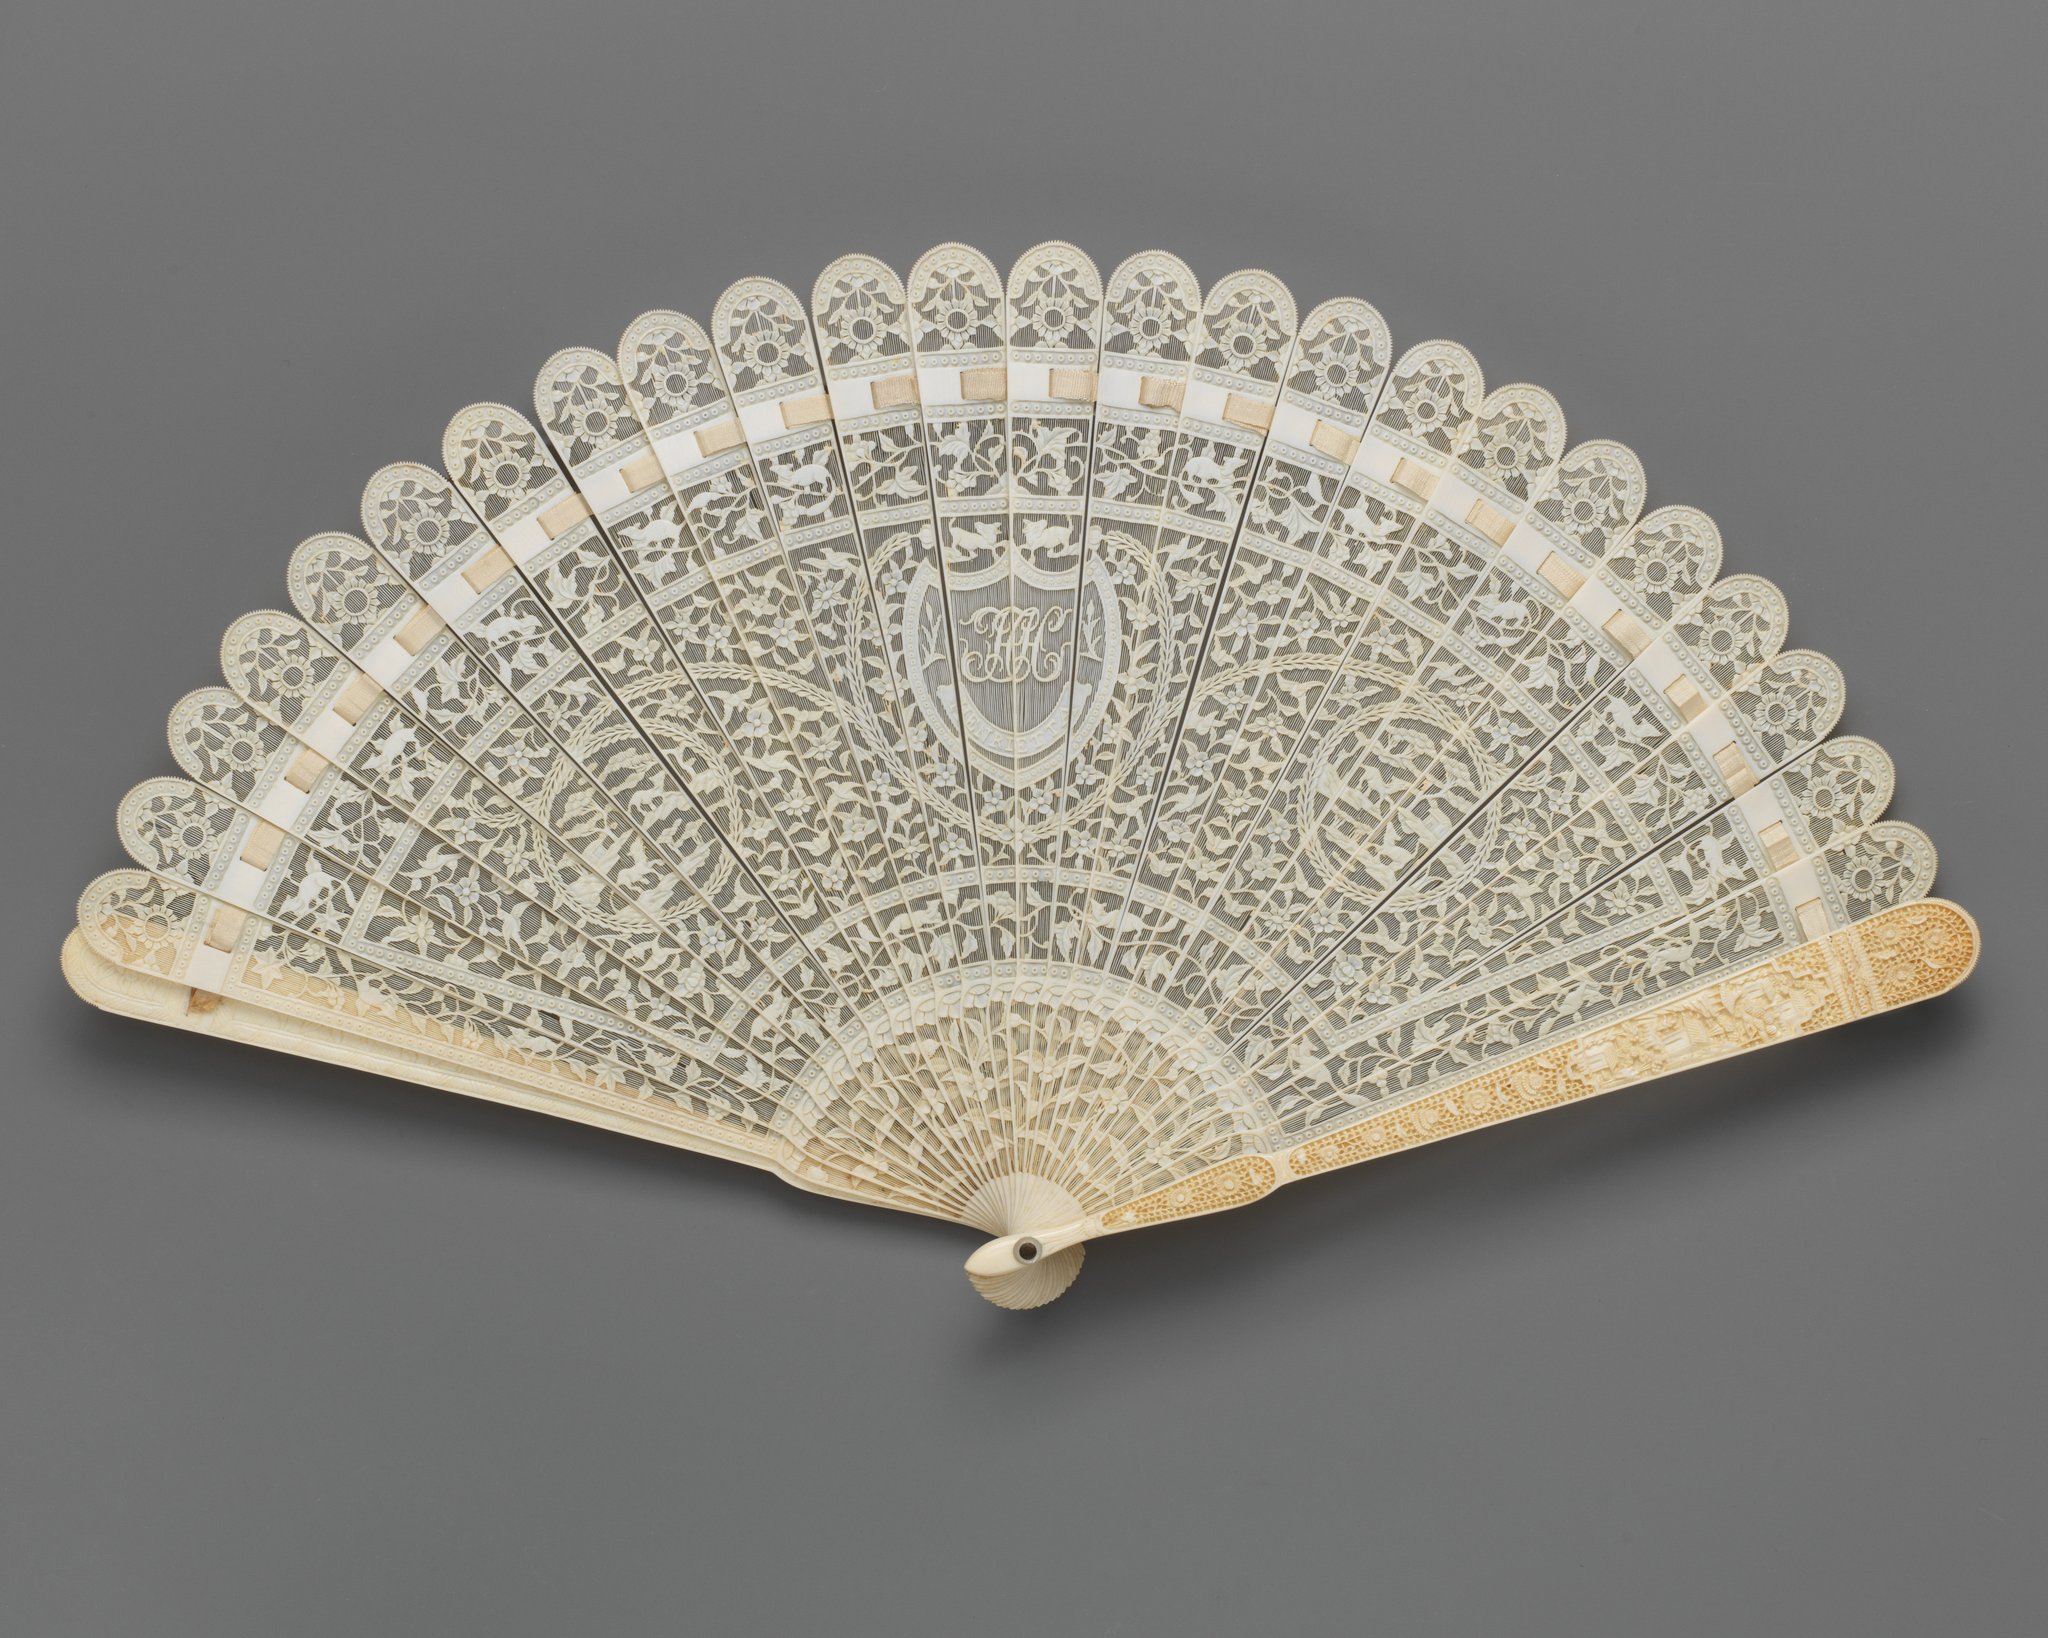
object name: fan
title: Brisé Fan, with representations of beasts in landscapes flanking HH monogram and the name "Henrietta"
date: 1801-1833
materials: ivory